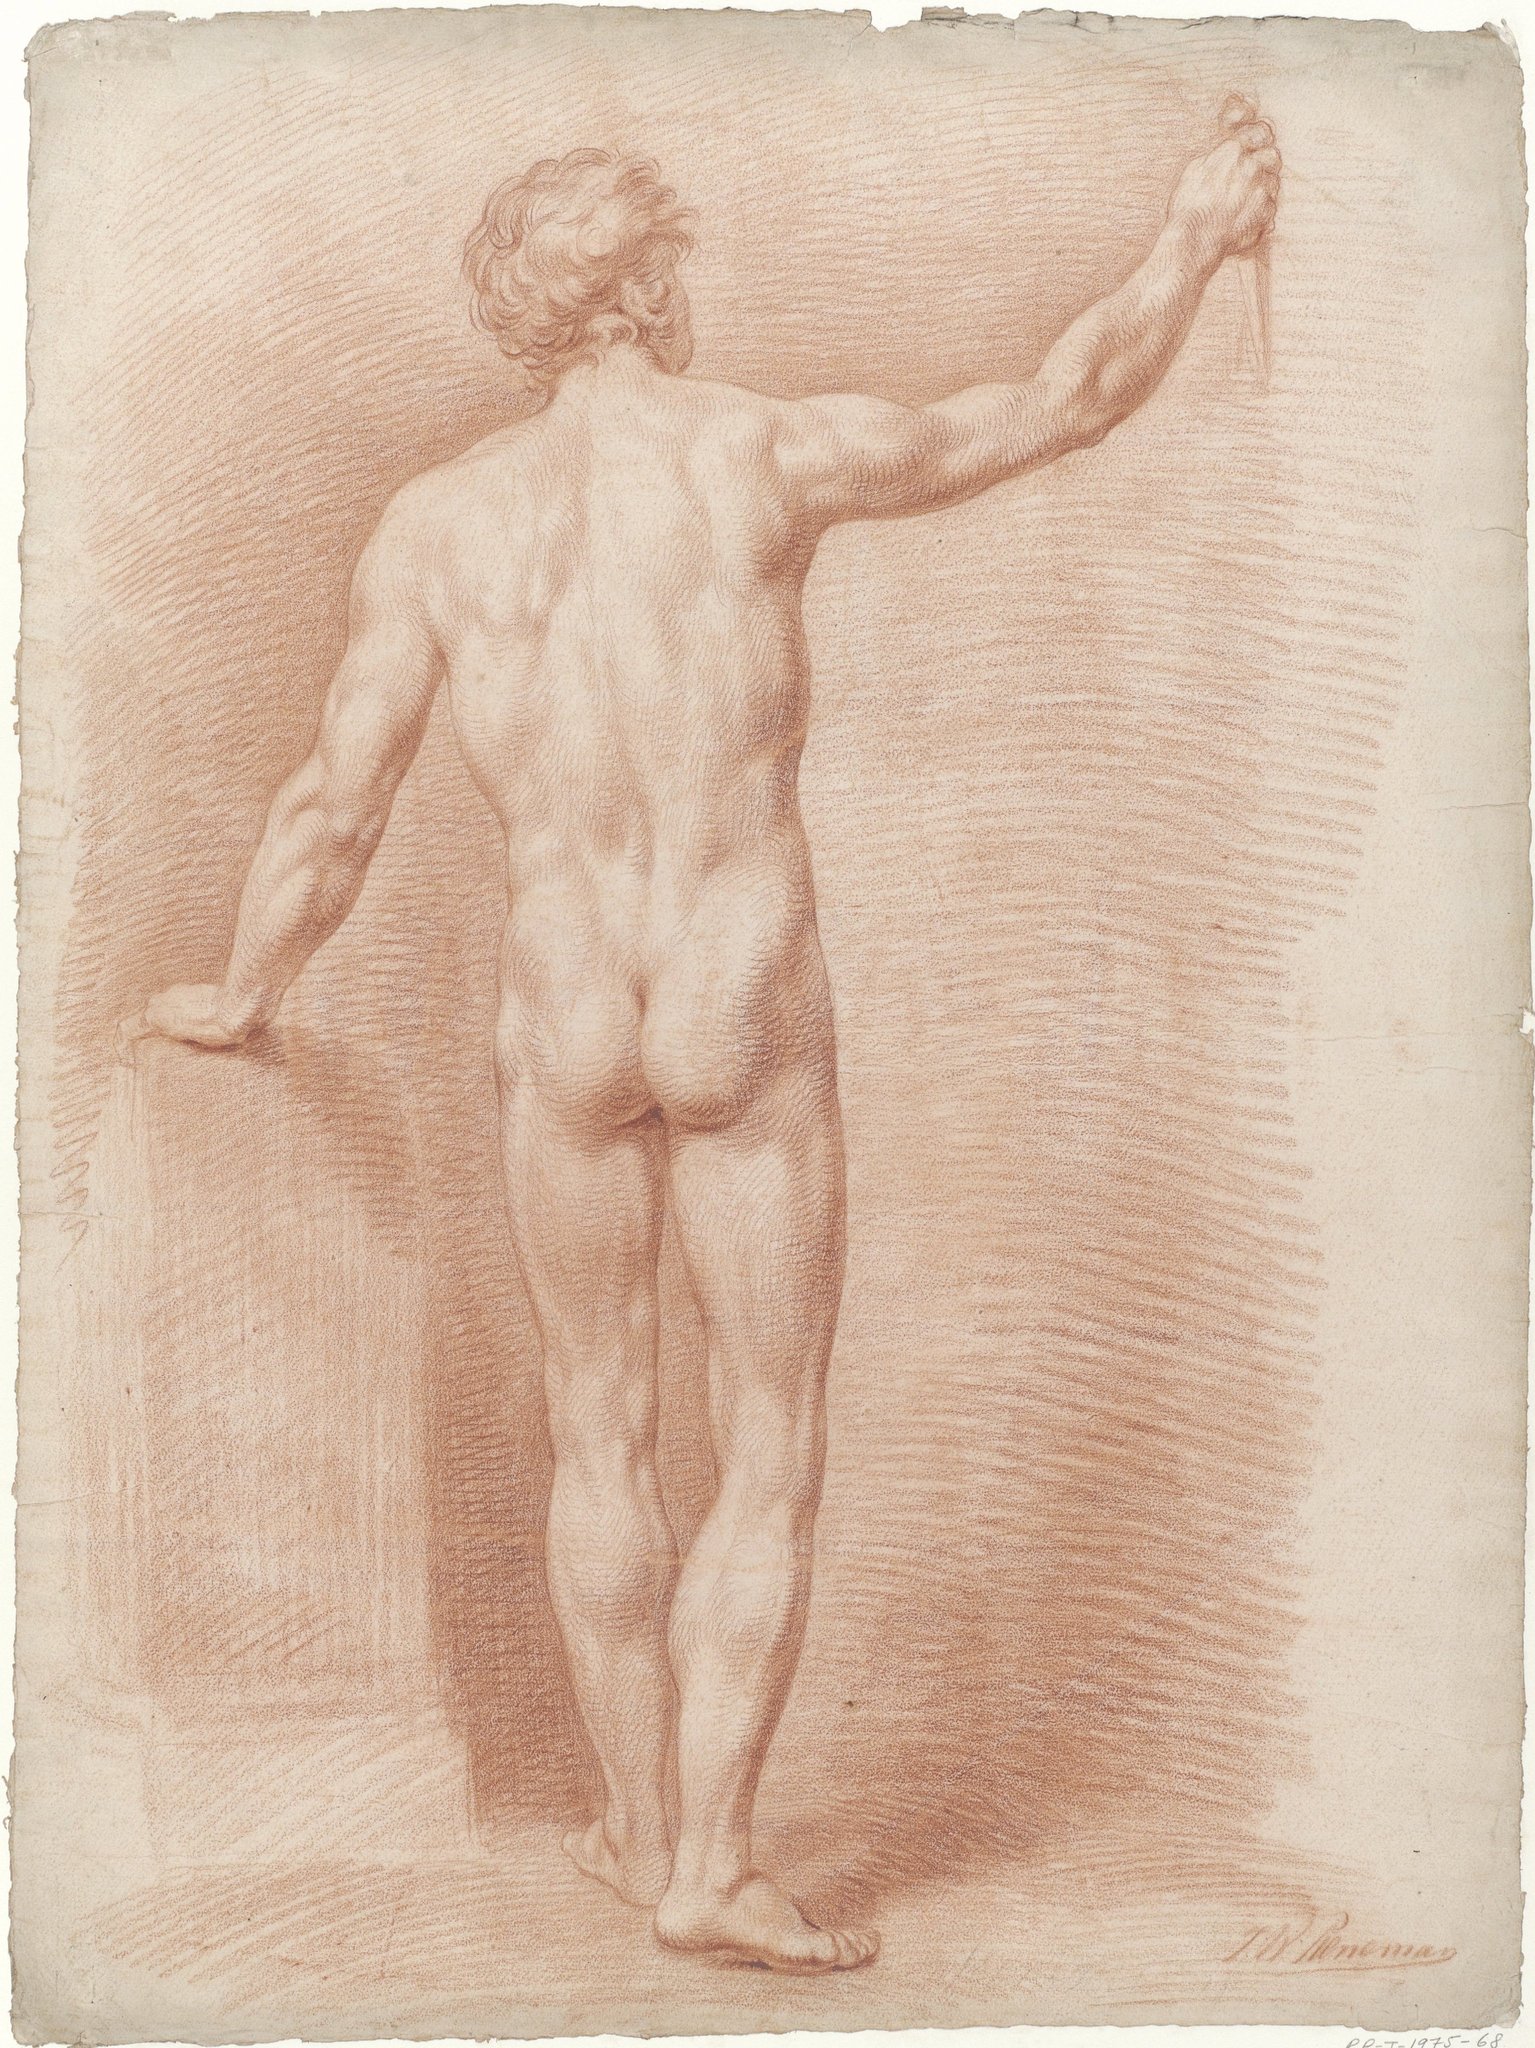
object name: drawing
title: Staand mannelijk naakt, op de rug gezien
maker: jan willem pieneman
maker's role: draughtsman, painter, print maker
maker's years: 1779-1853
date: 1802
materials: chalk, paper